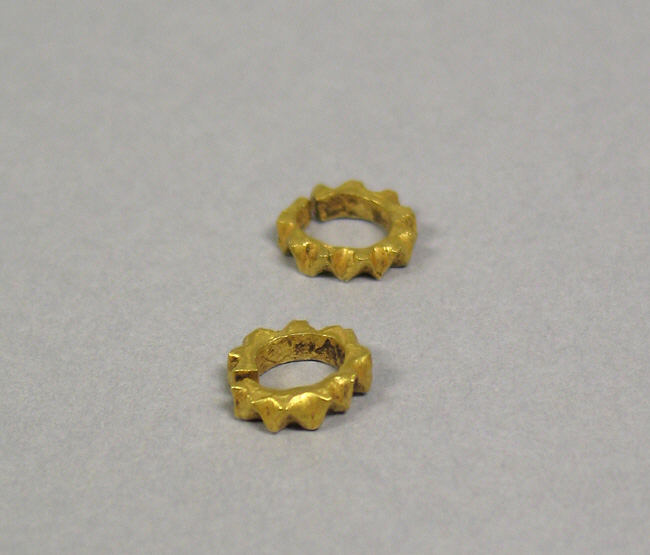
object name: pair of earring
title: Pair of Earrings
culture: indonesian, central java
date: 701-1200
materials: gold